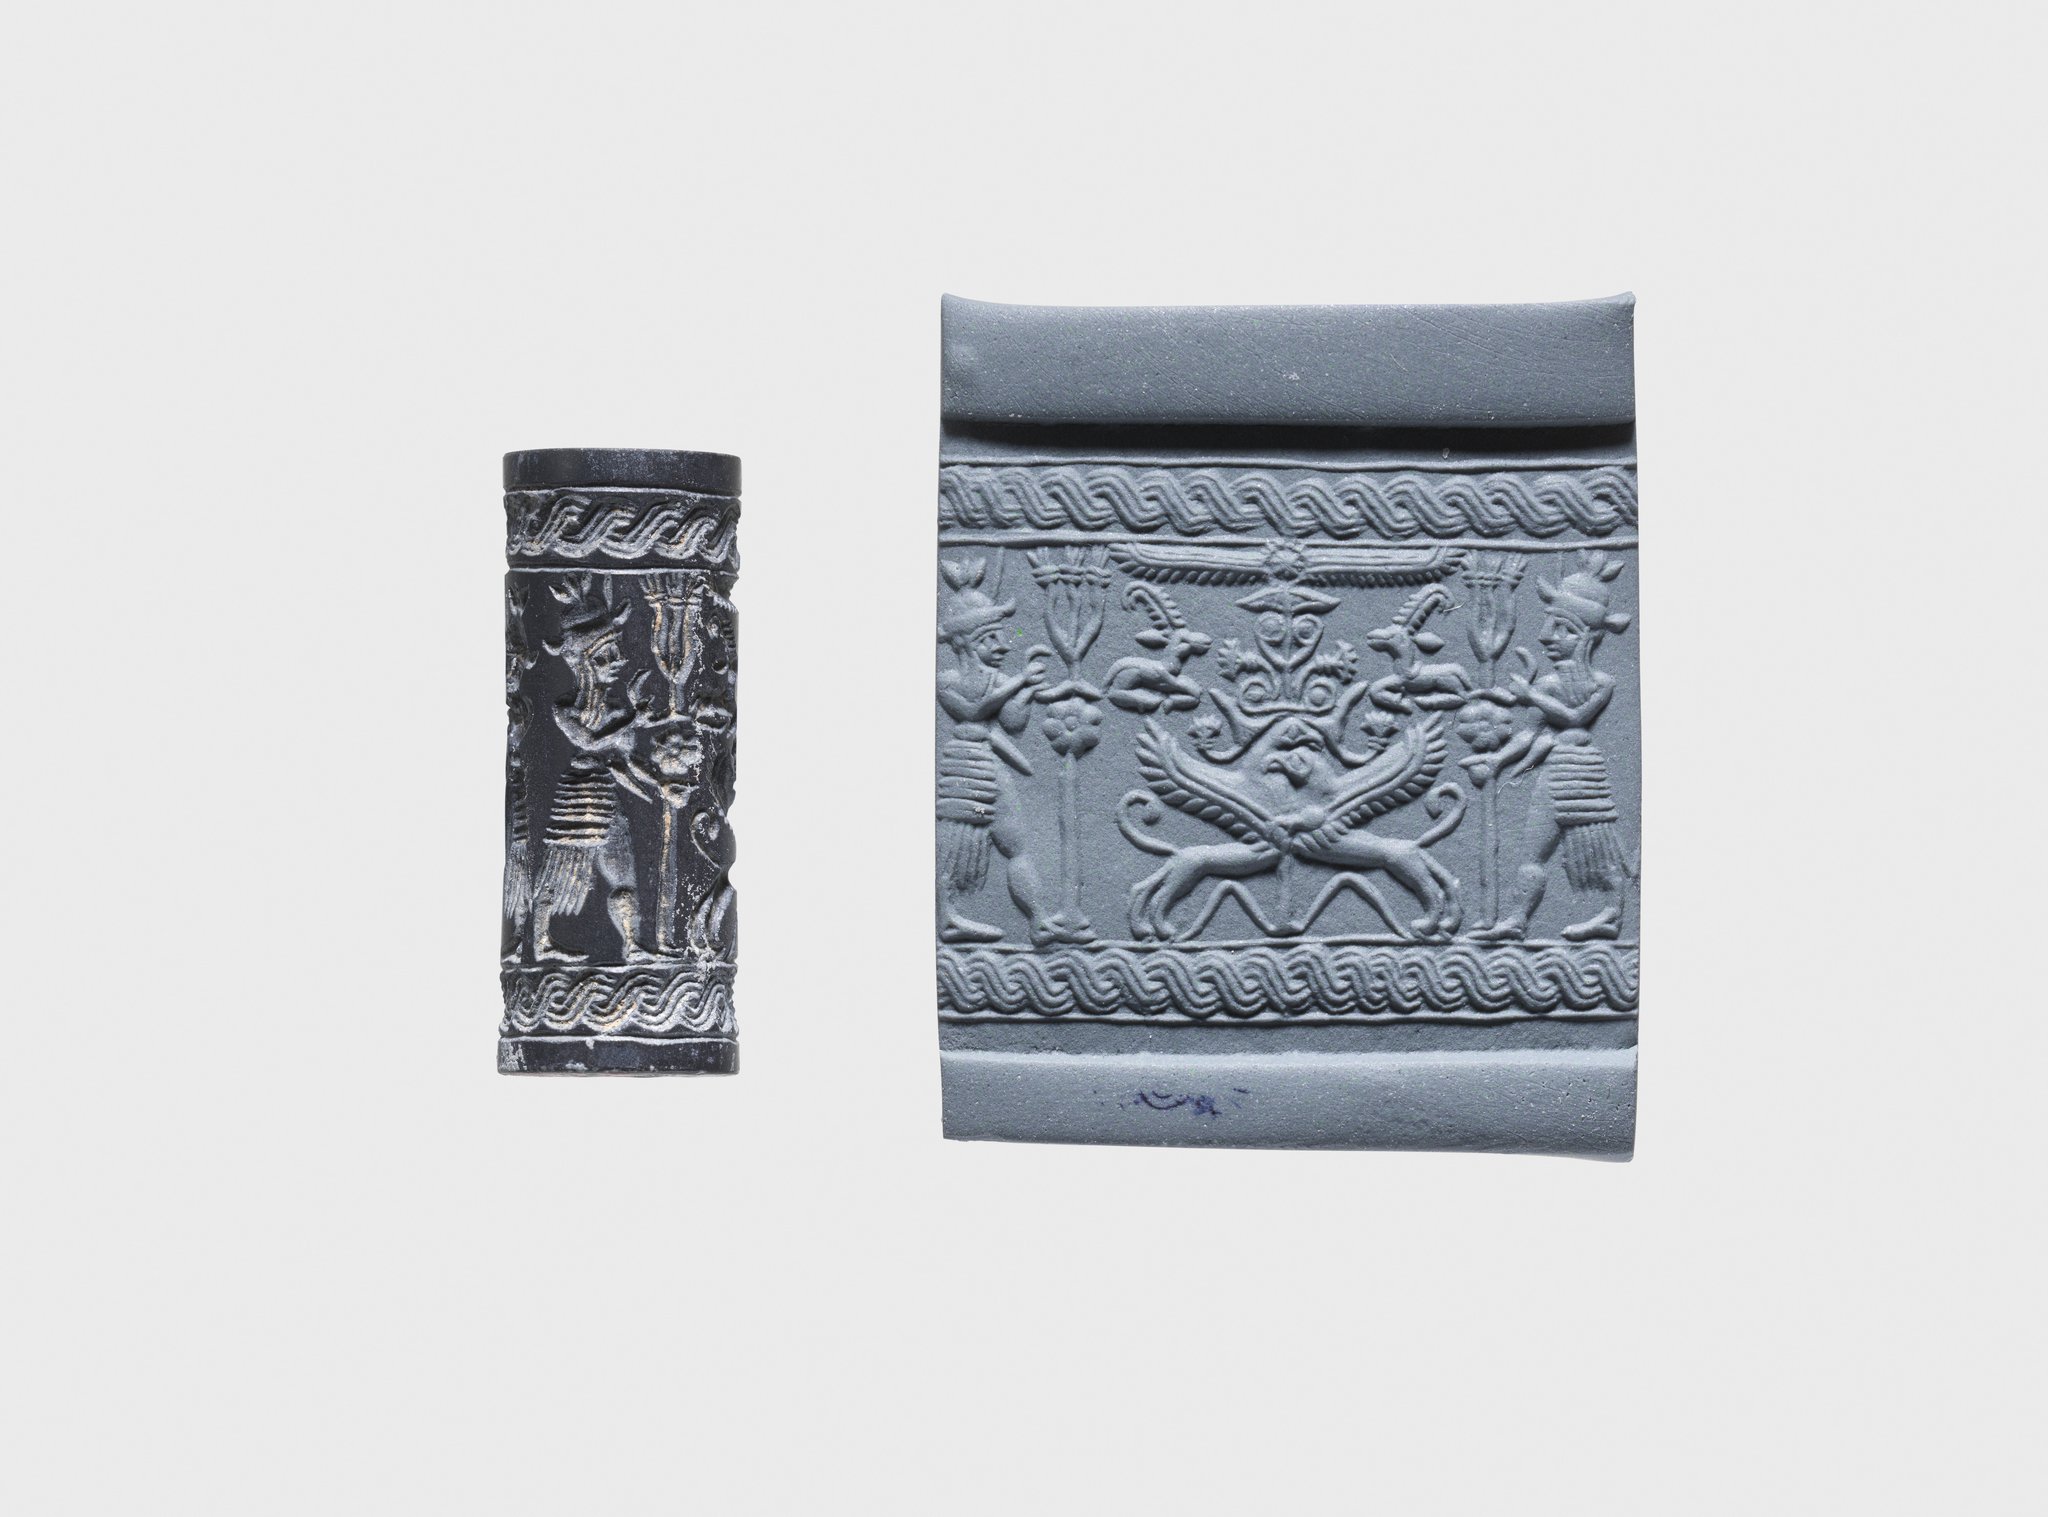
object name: cylinder seal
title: Cylinder seal and modern impression: weather gods framing heraldic griffins at tree below winged sun disc and ibexes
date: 1720-1650 BCE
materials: mineral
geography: syria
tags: griffins,gods,ibex